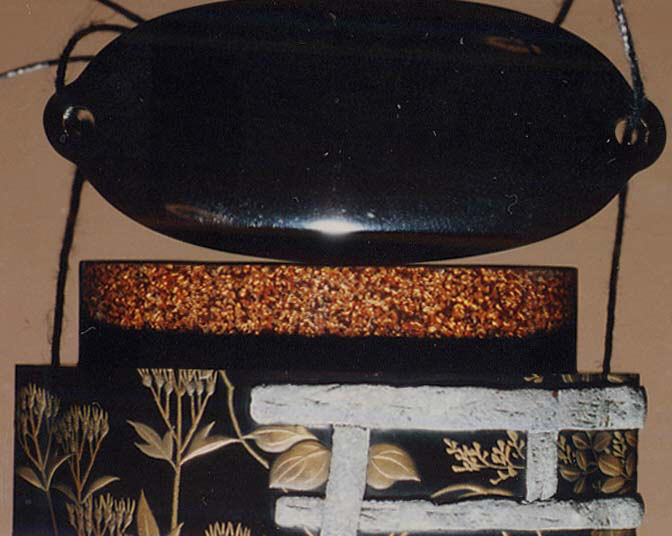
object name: inrō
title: Case (Inrō) with Design of "Nonomiya" (Shrine in the Fields), from The Tale of Genji, chapter 10 (obverse); Seven Autumn Flowers Growing beside a Torii and Fence, based on "Sakaki," a Chapter from The Tale of Genji (reverse)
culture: japanese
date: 1801-1900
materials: gold, lacquer, mother of pearl, pewter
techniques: fundame, inlay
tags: plants